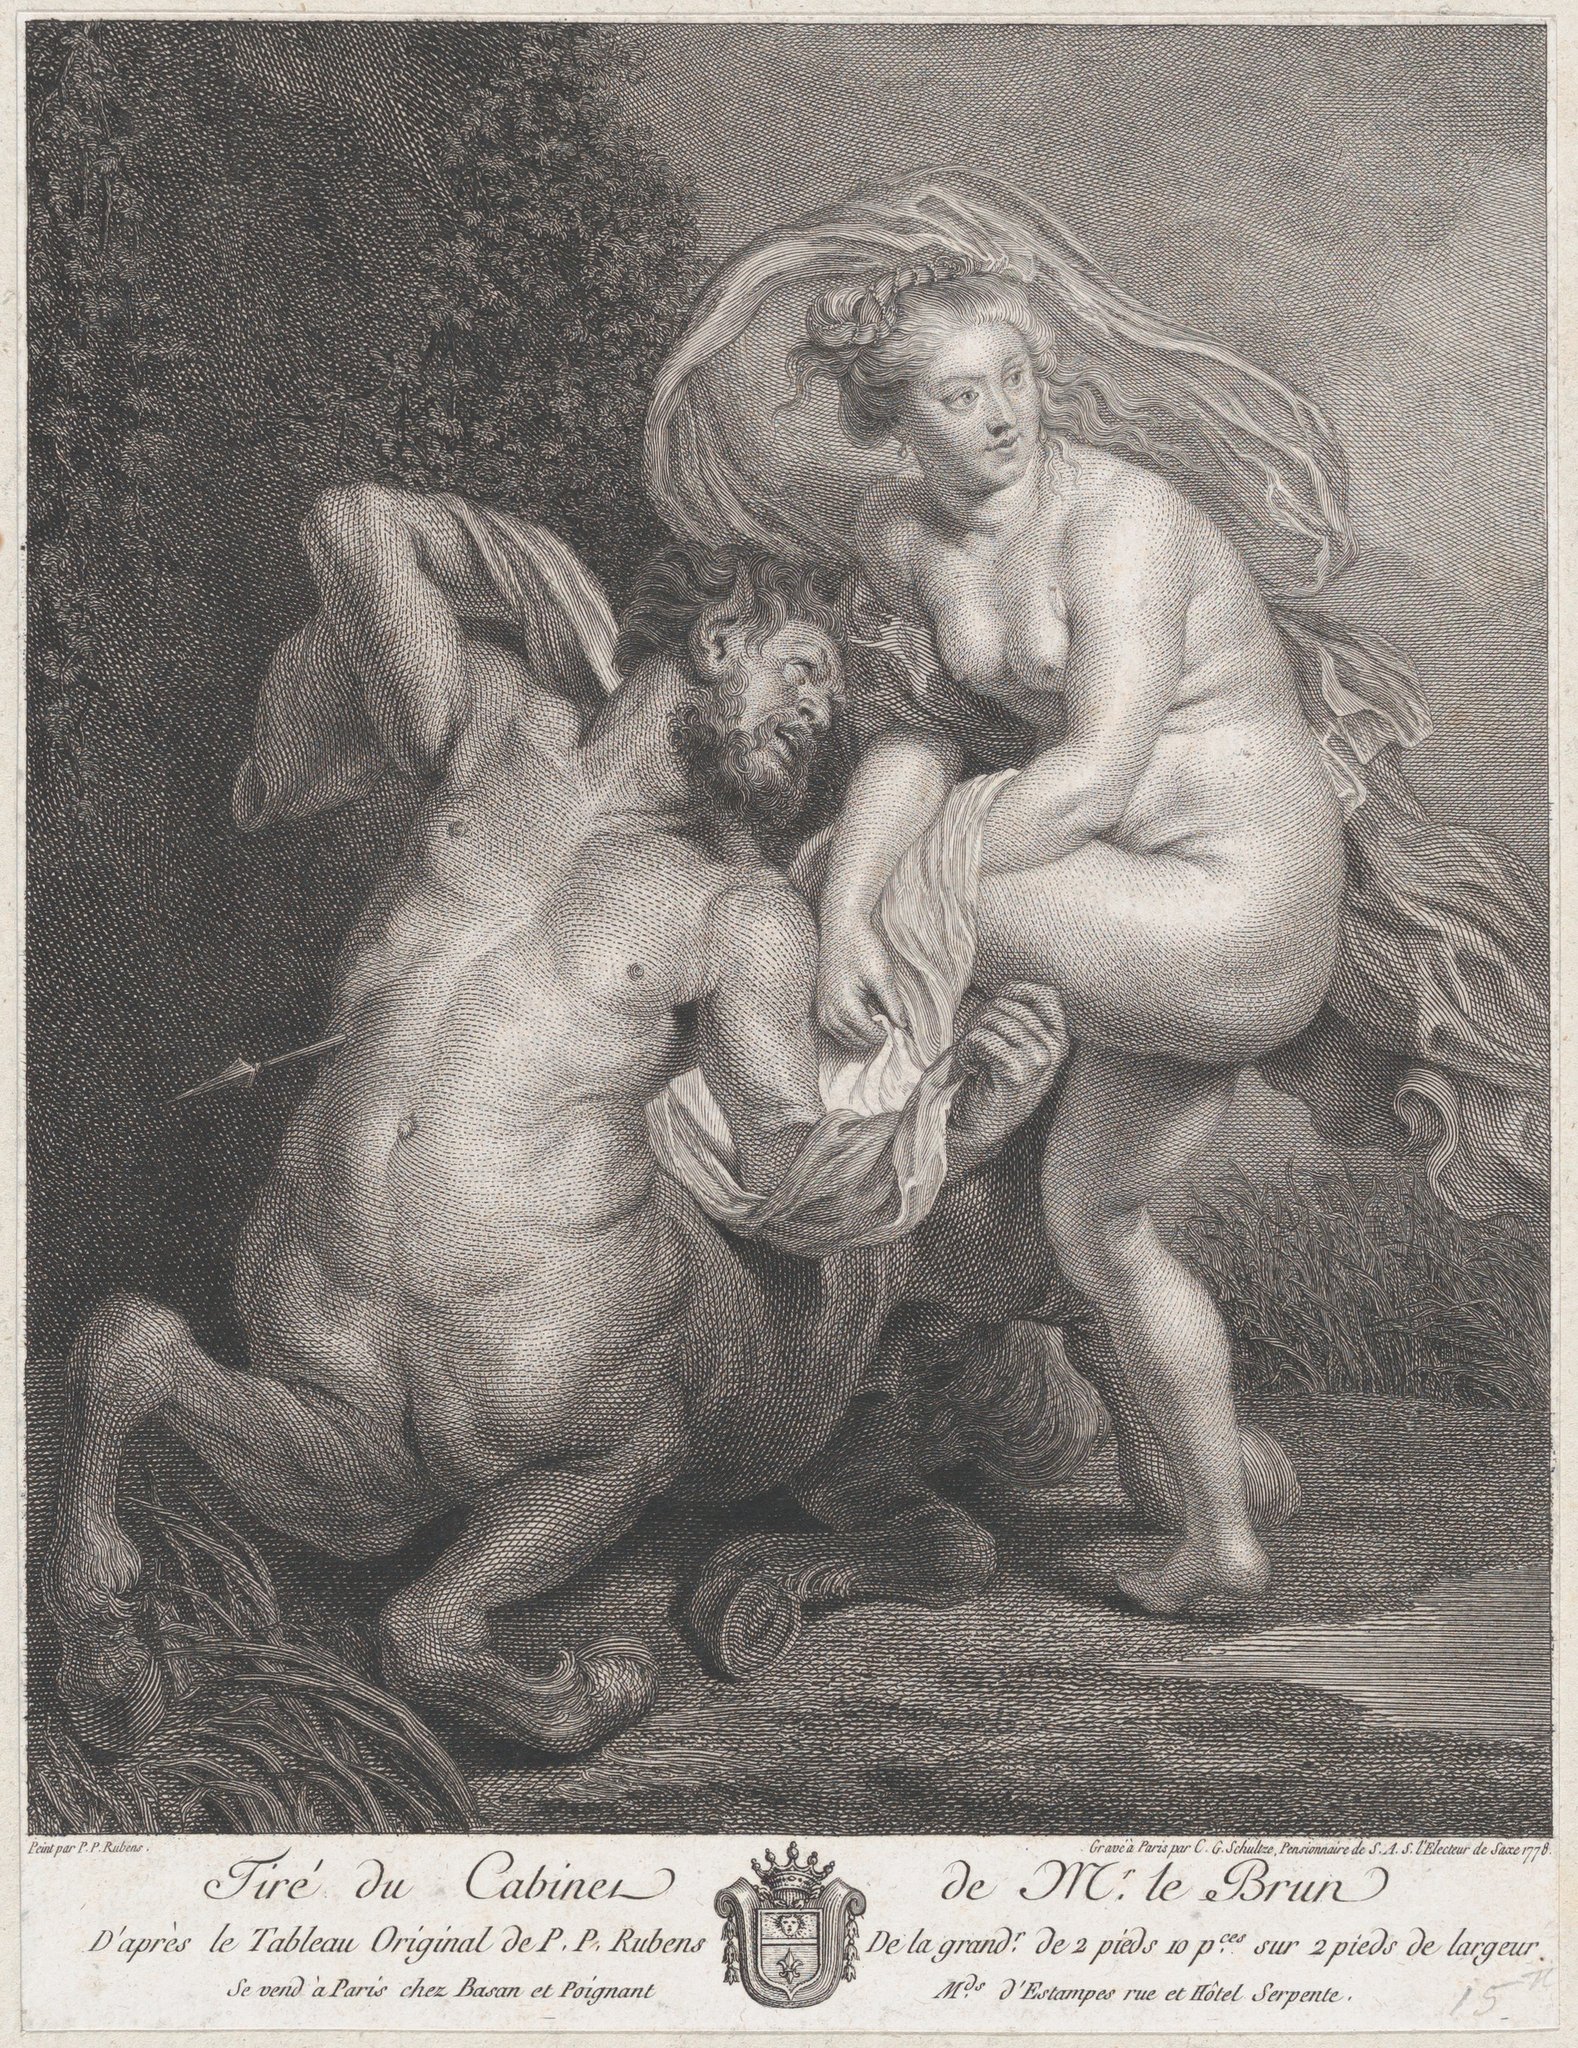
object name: print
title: Deianeira receiving the poisoned tunic from Nessus, and the wounded centaur falling to the ground at left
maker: christian gottfried schultze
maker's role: artist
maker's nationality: german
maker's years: 1749-1819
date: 1778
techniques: engraving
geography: paris